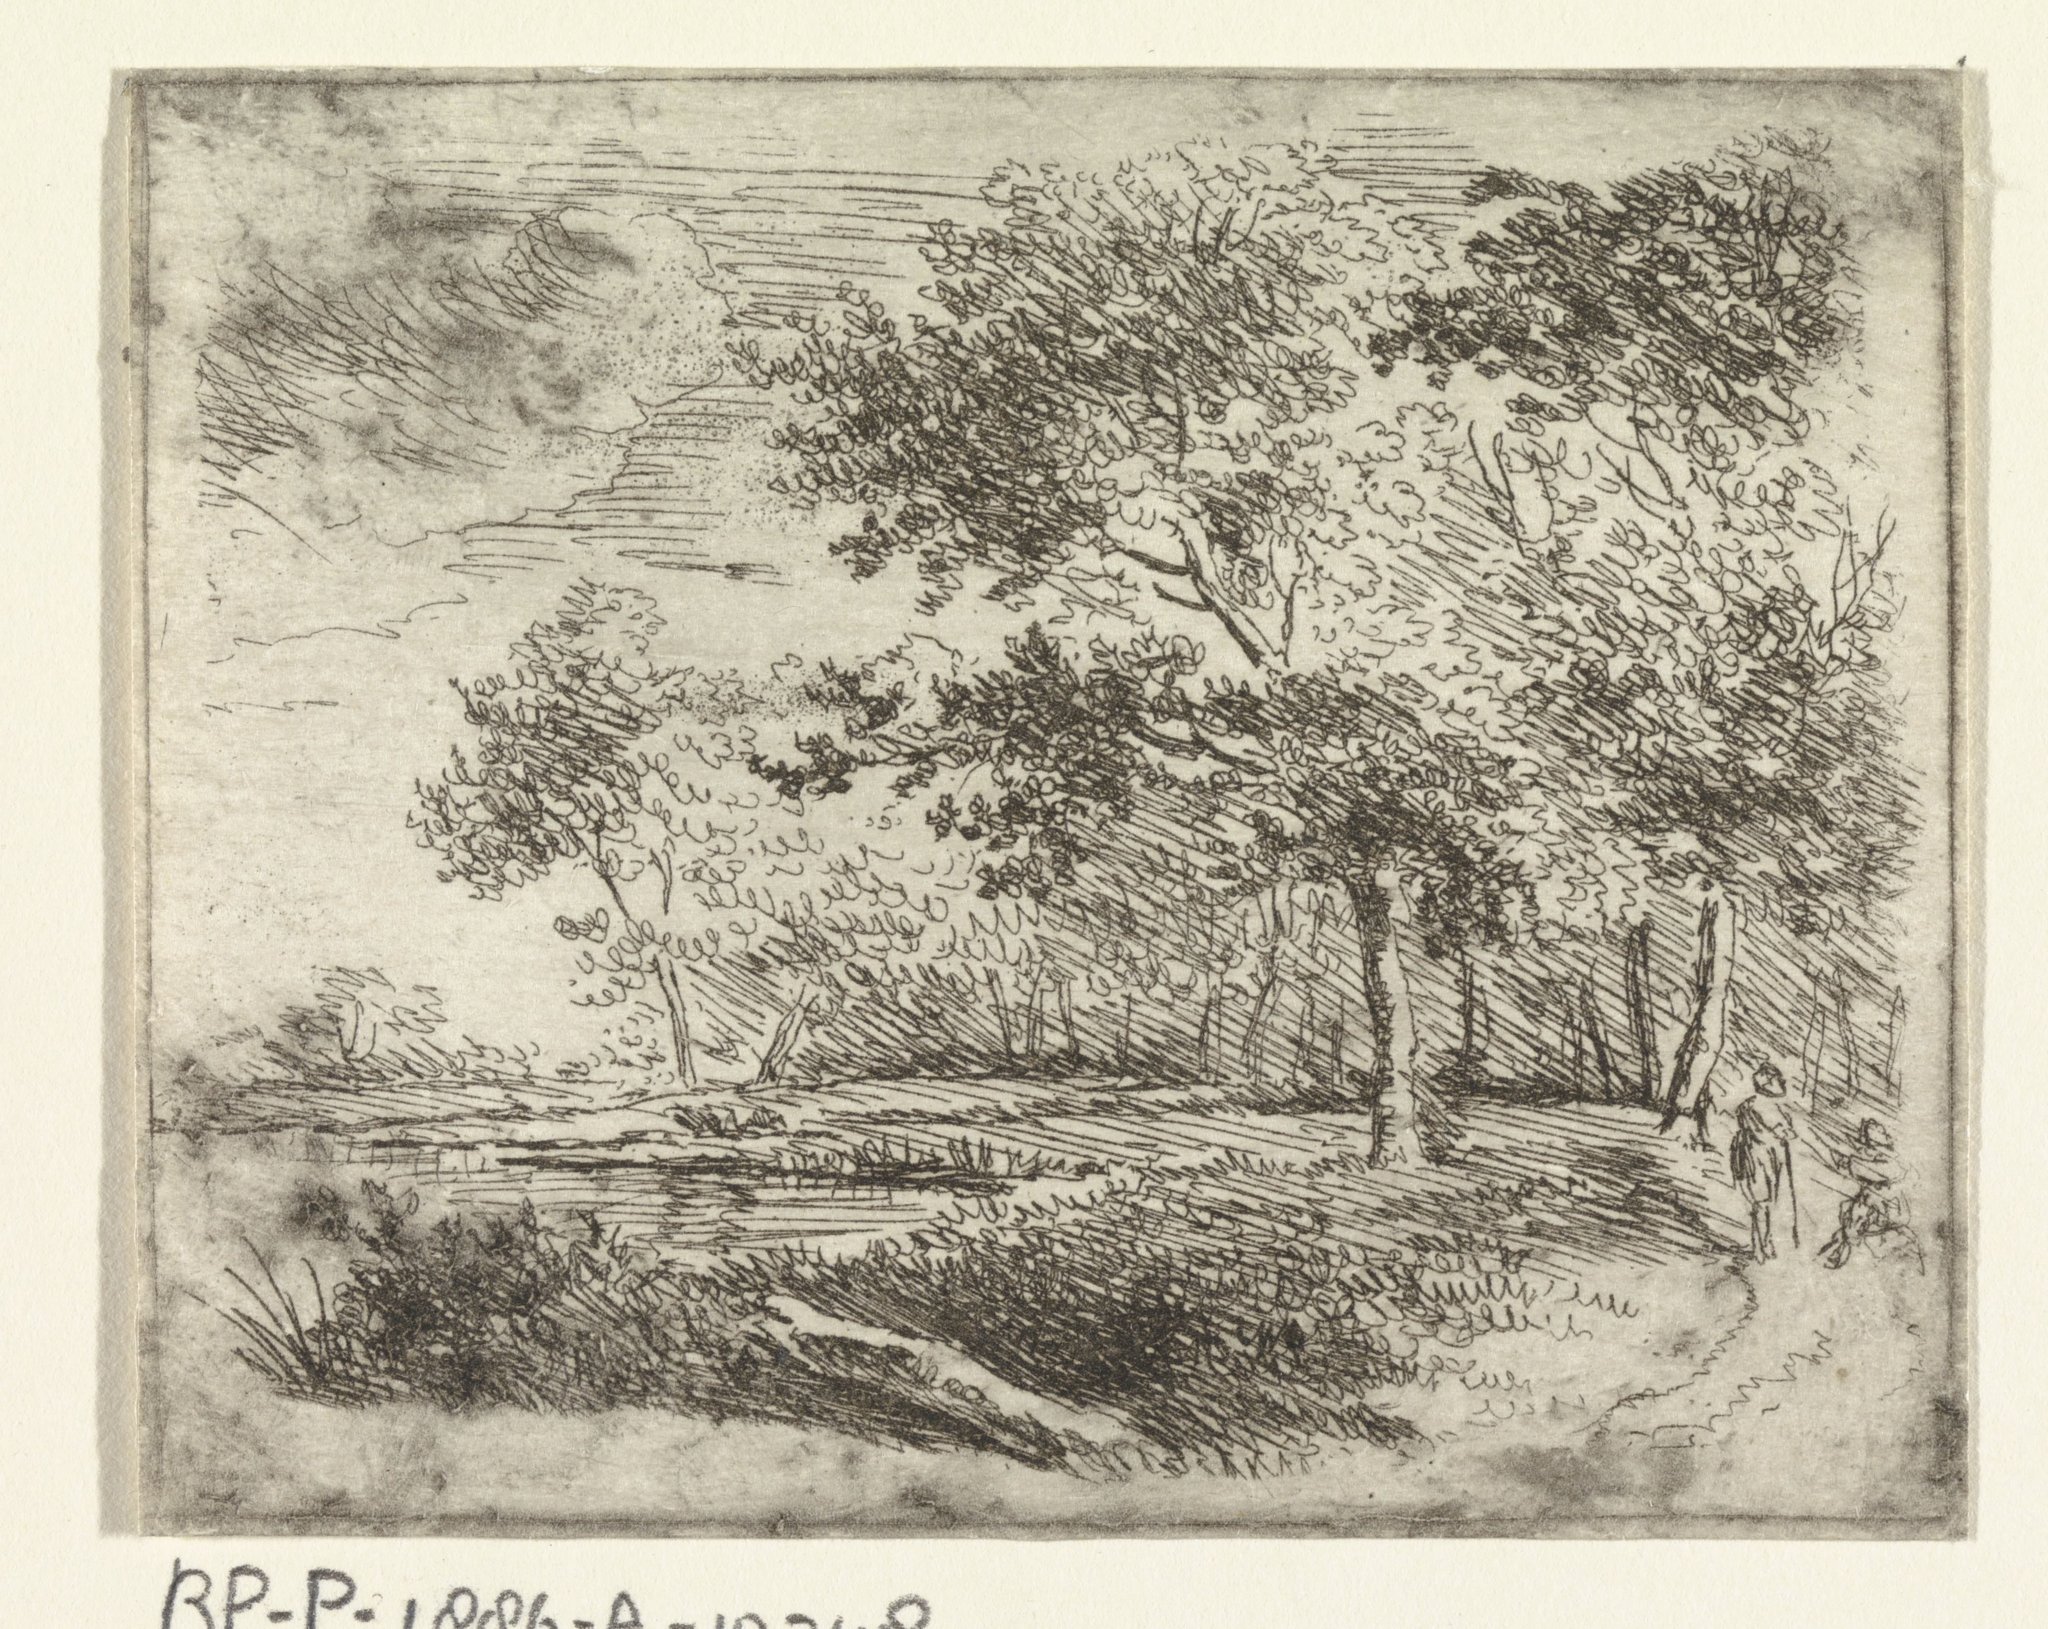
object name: print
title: Boslandschap met twee figuren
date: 1739-1851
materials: paper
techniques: etching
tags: landscapes (+ landscape with figures, staffage)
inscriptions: collector's mark: Lugt 2228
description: Boslandschap met rechts een figuur, leunend op een stok, in gesprek met een zittende figuur. Links een meer.